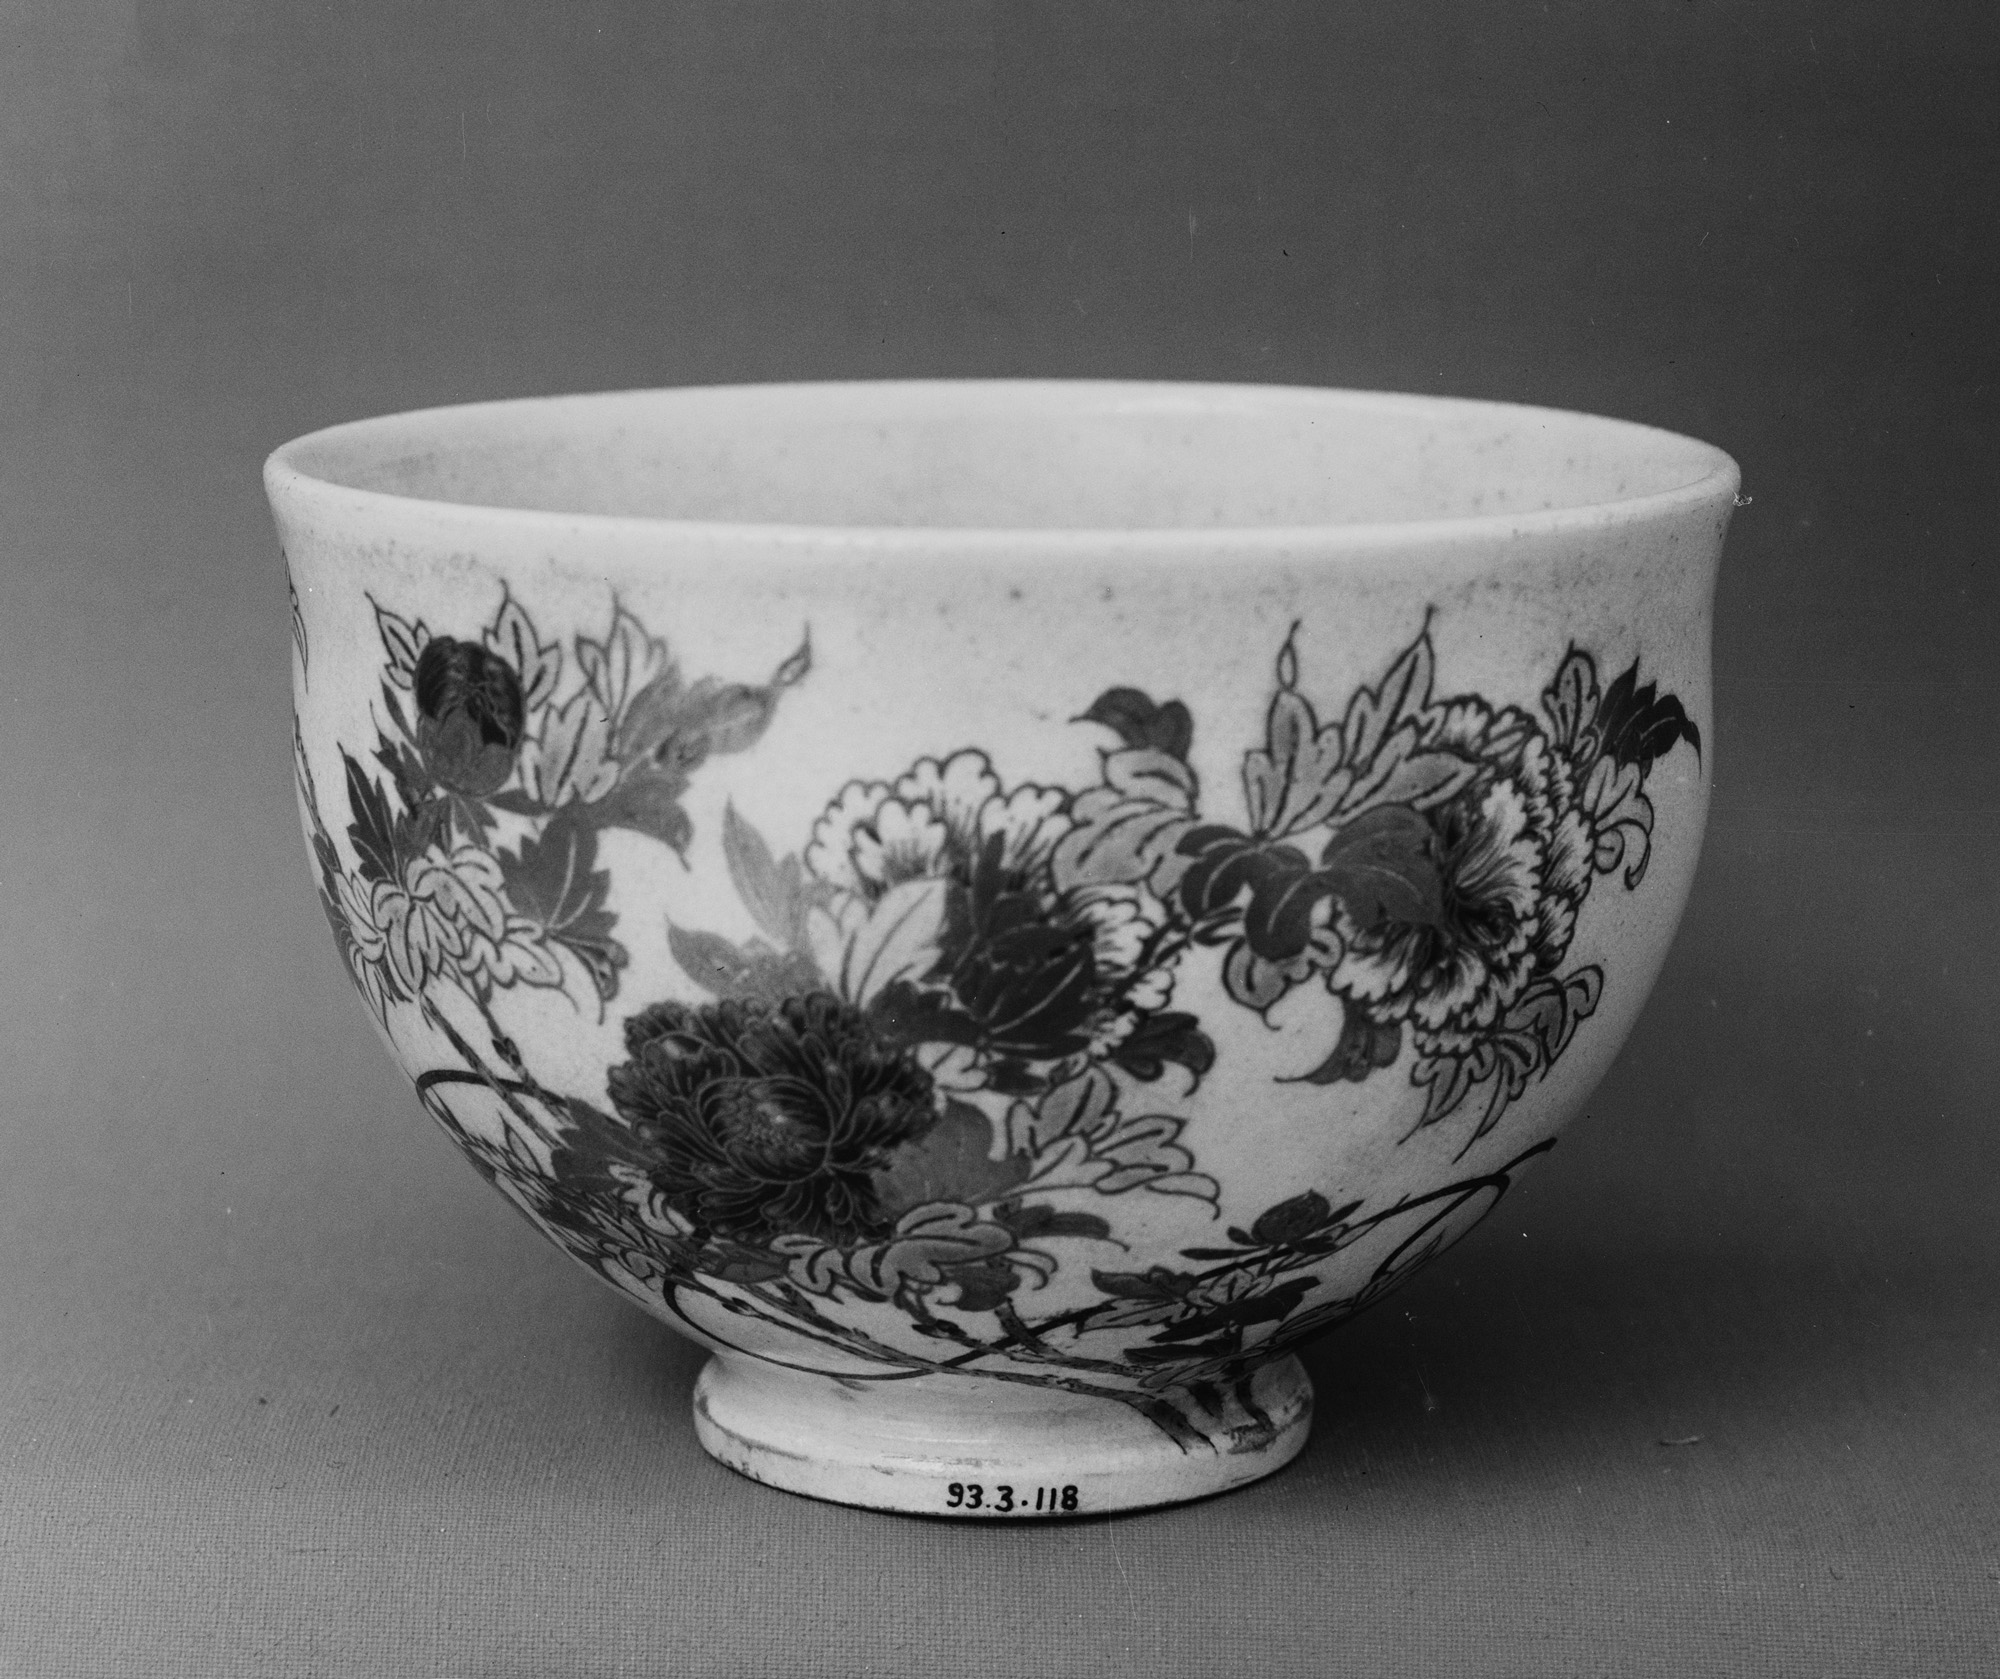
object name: teabowl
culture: japanese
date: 1800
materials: clay, enamel, glaze, gold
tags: flowers